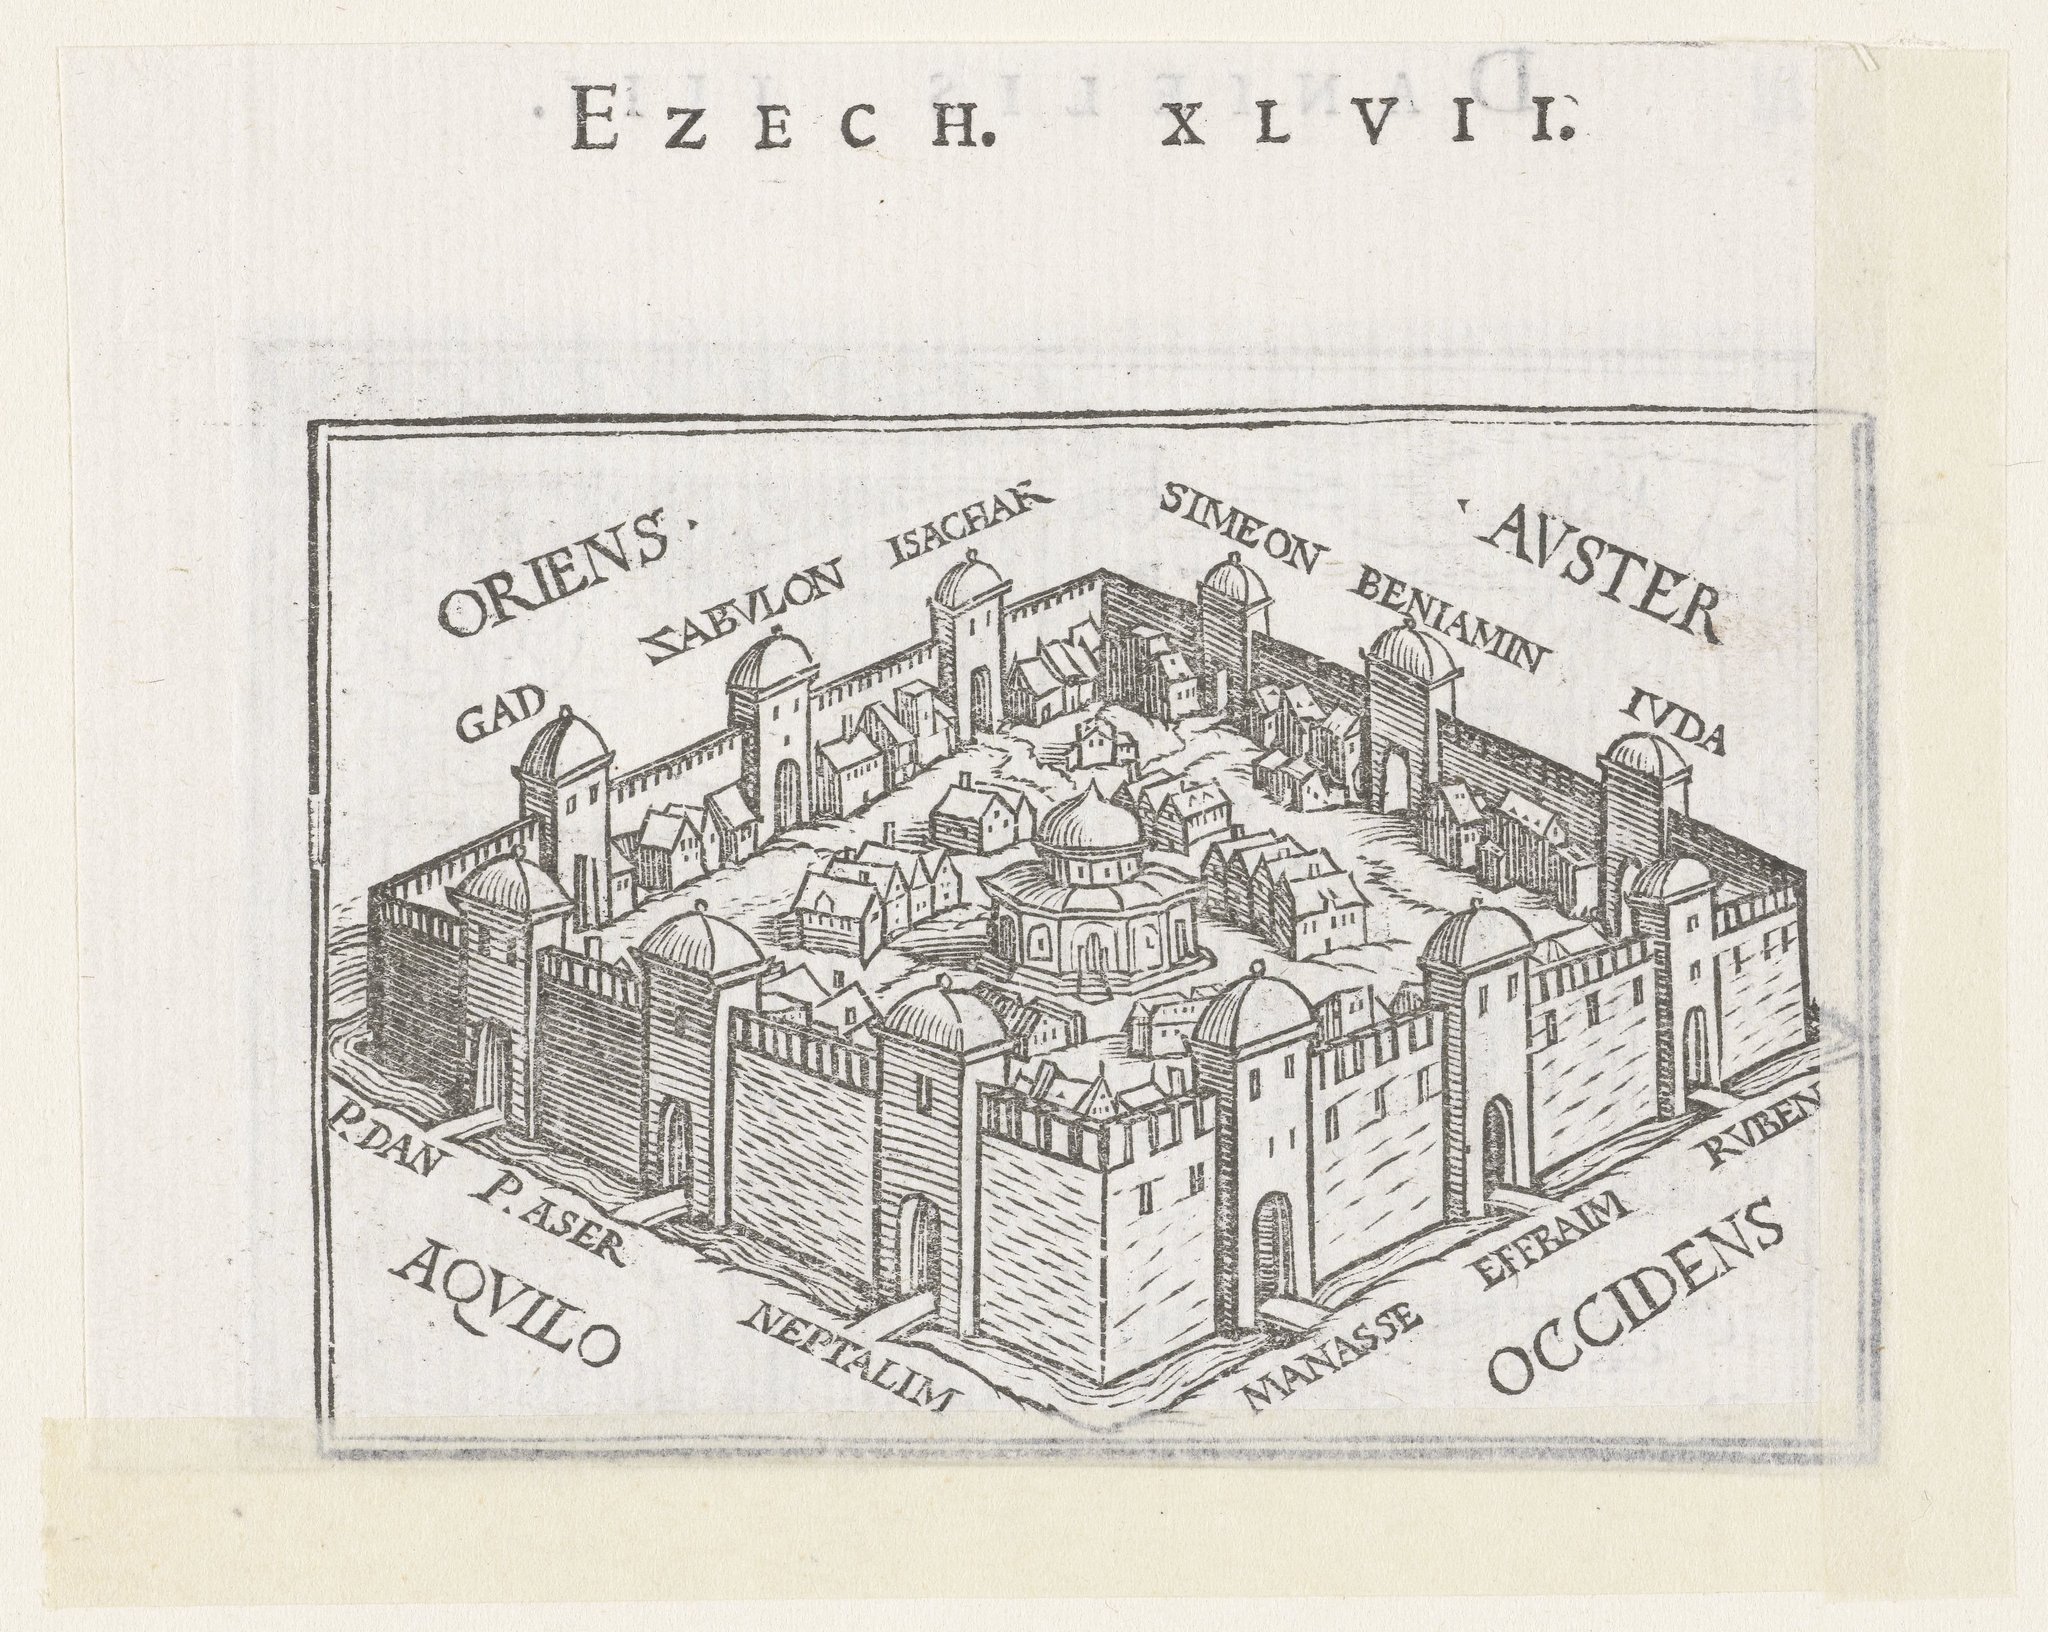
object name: print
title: Hemelse stad in visioen van Ezechiël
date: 1538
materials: paper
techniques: woodcut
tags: ezekiel's vision of the new temple (ezekiel 40 - 47:12)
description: De hemelse stad met de nieuwe tempel zoals Ezechiël deze ziet in een visioen. De windrichtingen zijn aangeduid en bij de poorten staan namen van de stammen van Israël. In de marge boven de afbeelding staat de tekst Ezech. XLVII.